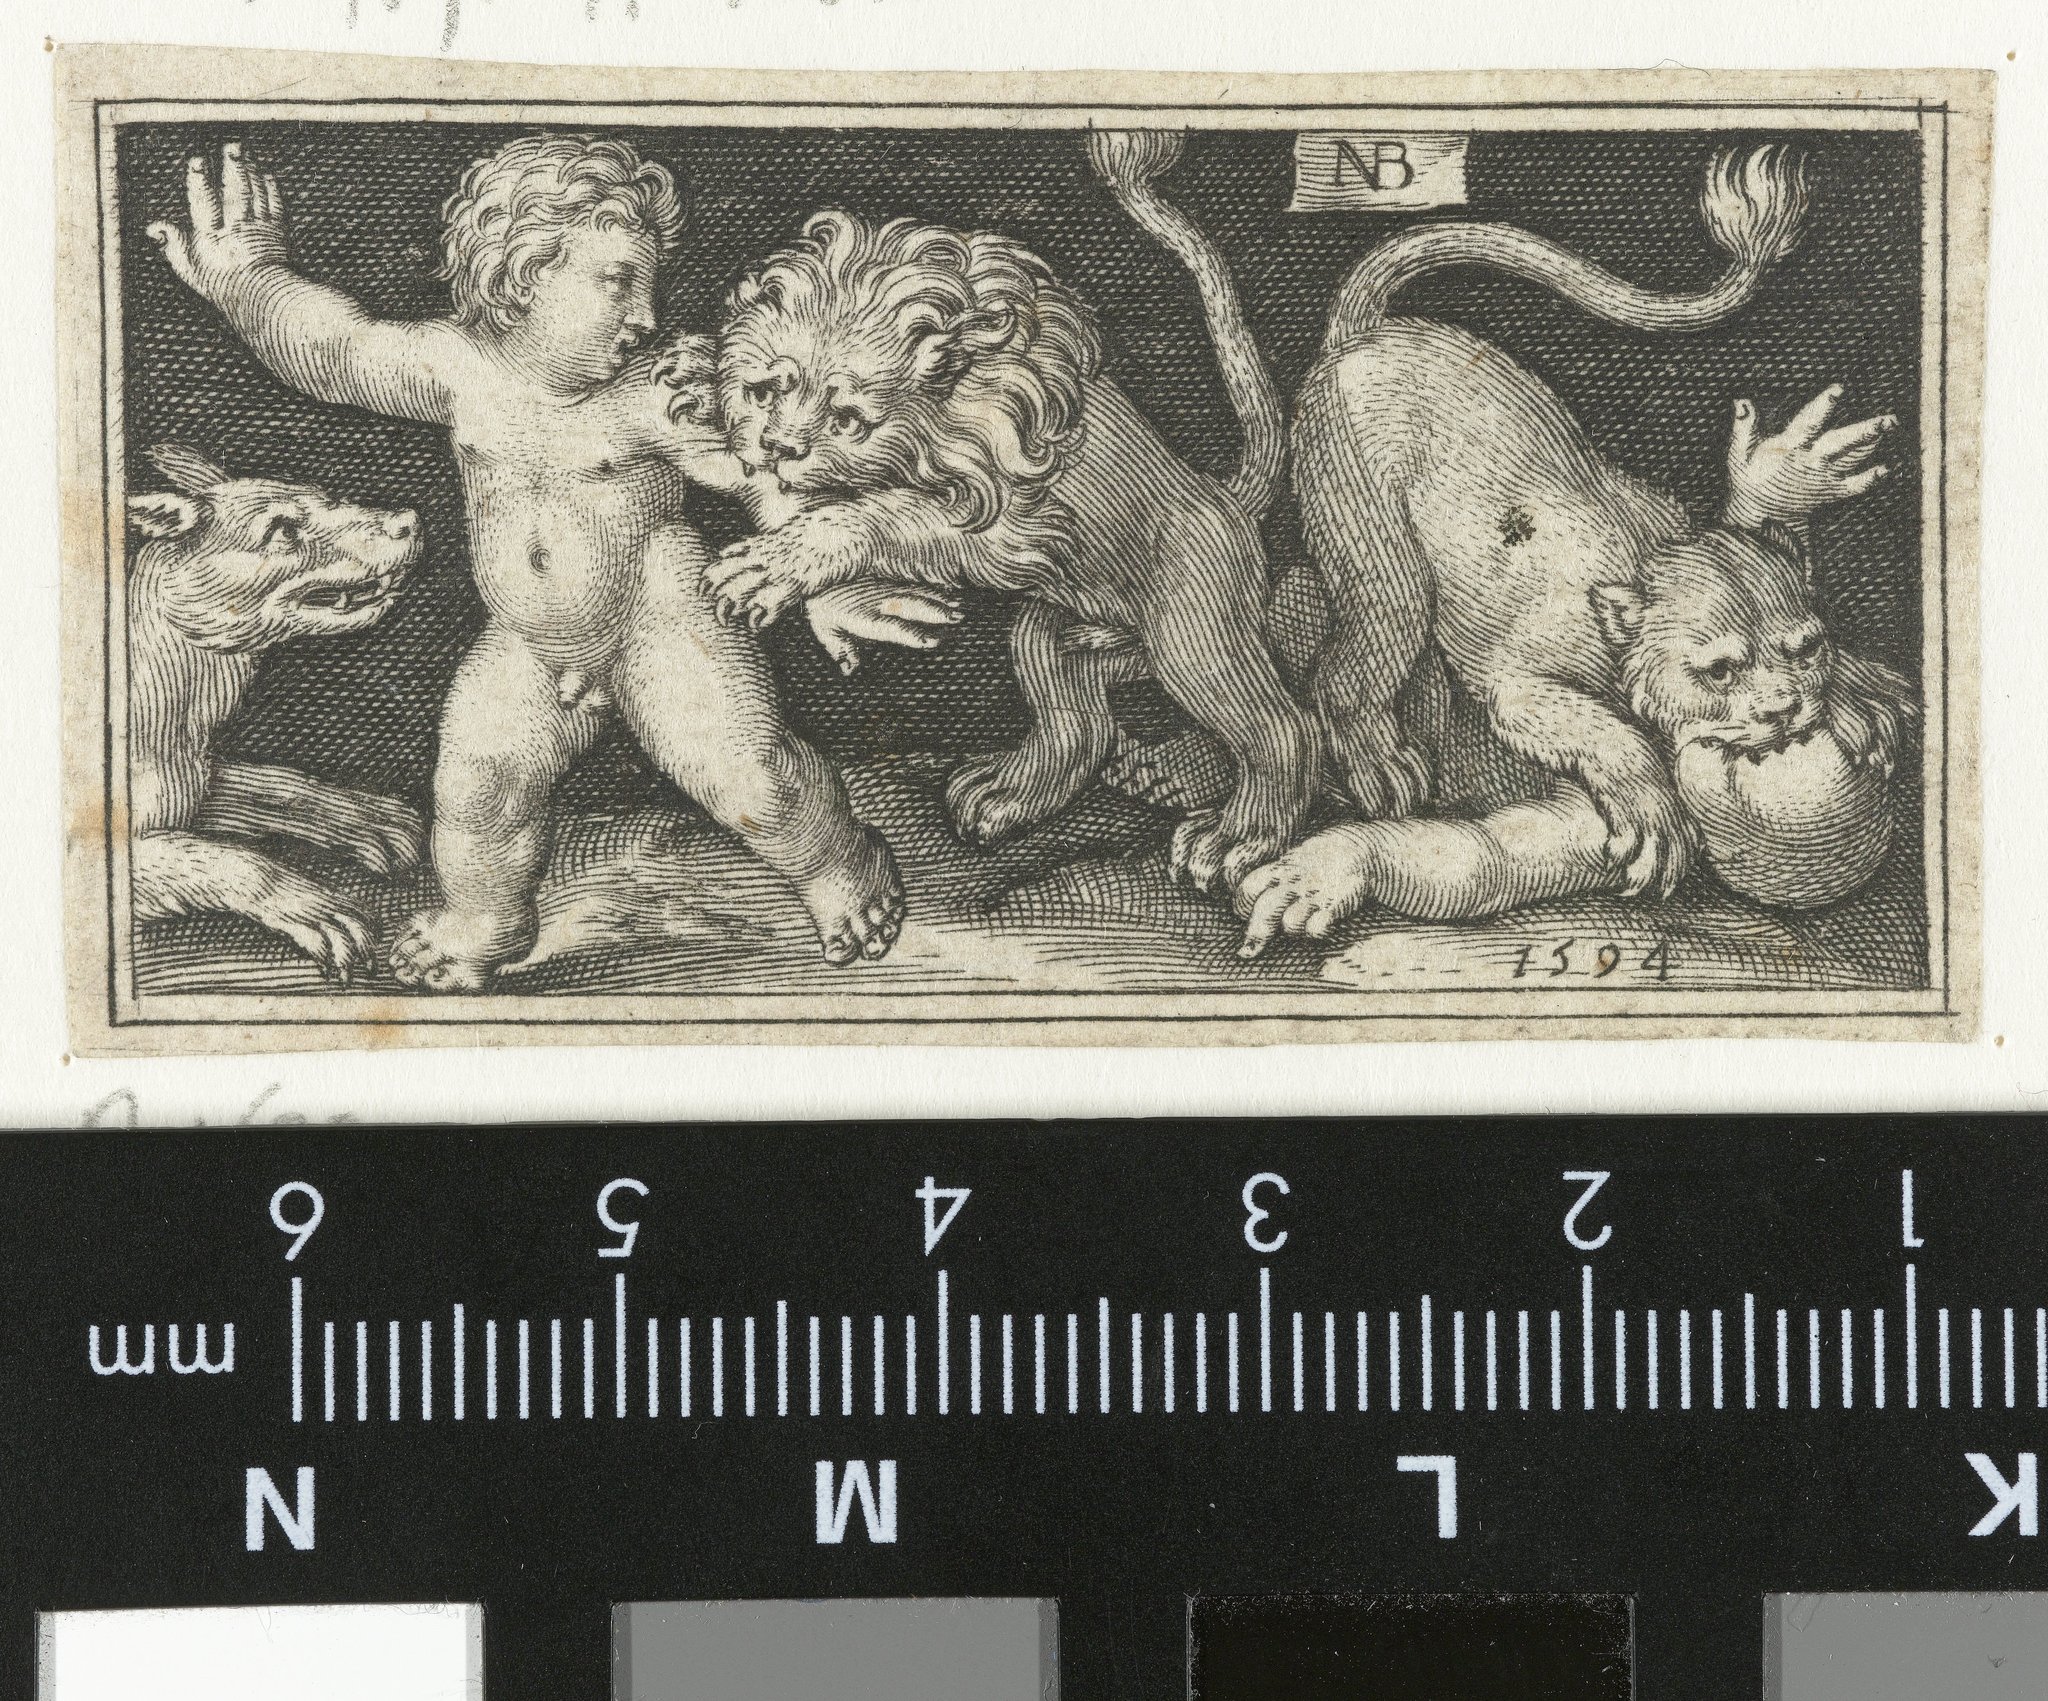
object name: print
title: Leeuw en leeuwin verscheuren putti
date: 1594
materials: paper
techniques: engraving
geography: netherlands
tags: beasts of prey, predatory animals: lion, cupids: 'amores', 'amoretti', 'putti', man and animal (+ animal with prey)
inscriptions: collector's mark: Lugt 2228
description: R. de Rosey nr. 193. Prent uit serie van twaalf kleine prentjes met dieren uit fabels. Eenzelfde serie is ook uitgegeven door Visscher (Fuhring, 1989).